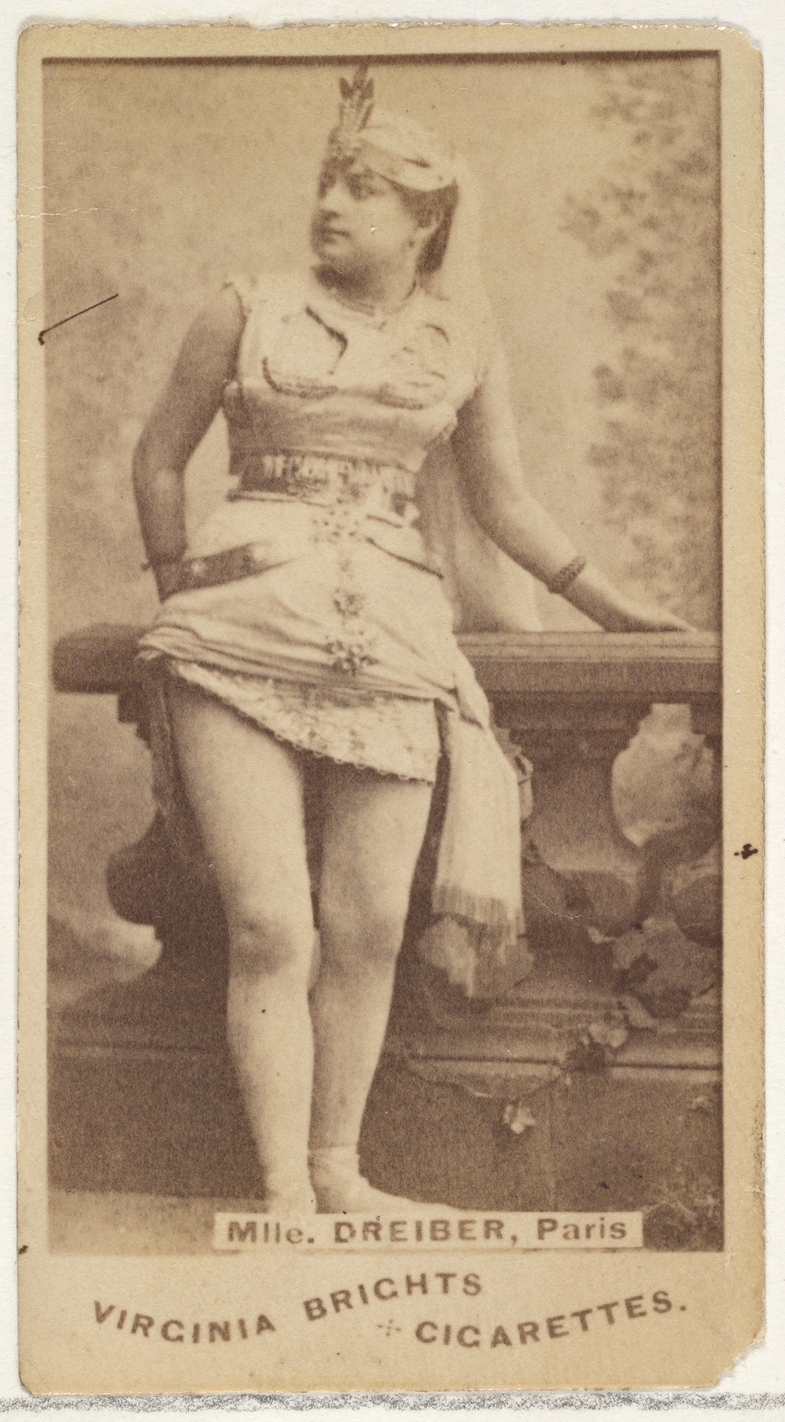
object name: photograph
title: Mlle. Dreiber, Paris, from the Actors and Actresses series (N45, Type 1) for Virginia Brights Cigarettes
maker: allen & ginter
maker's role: publisher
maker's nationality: american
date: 1888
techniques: albumen silver print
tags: portraits,women,actresses